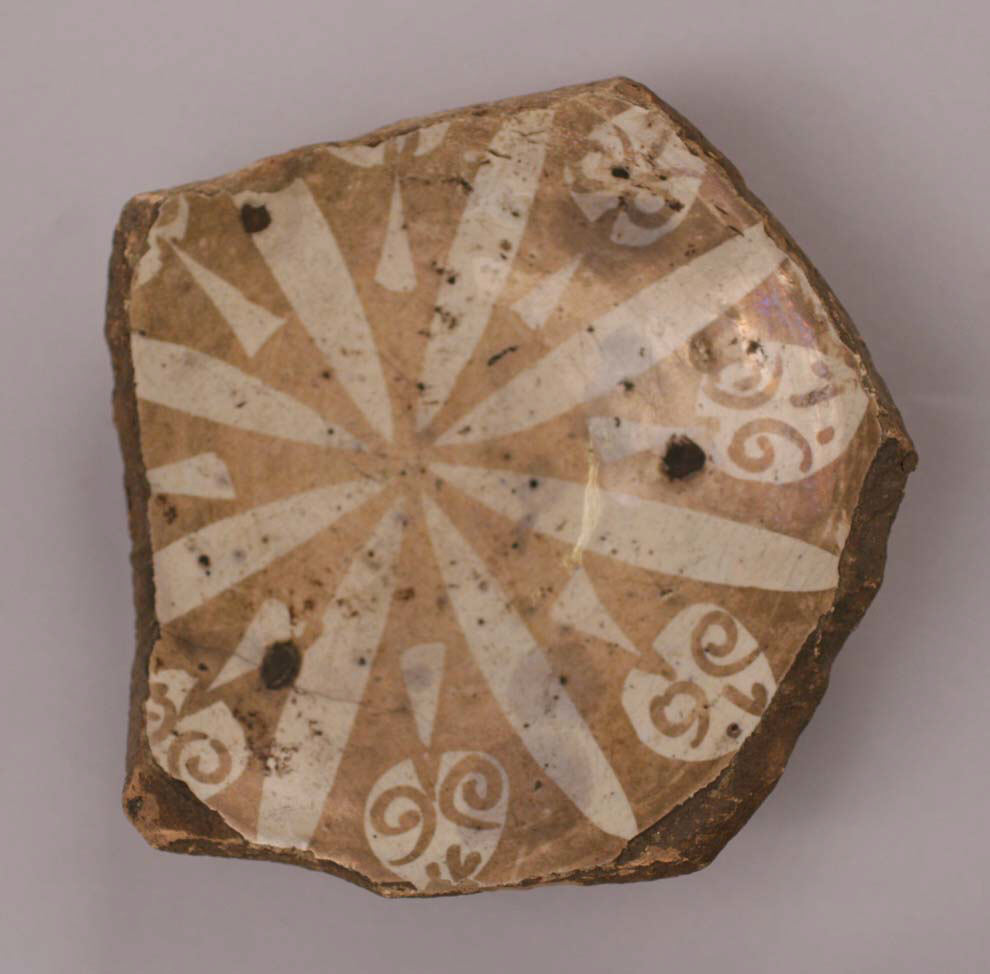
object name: fragment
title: Fragment of a Bowl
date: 1401-1500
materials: earthenware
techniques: glazing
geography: spain